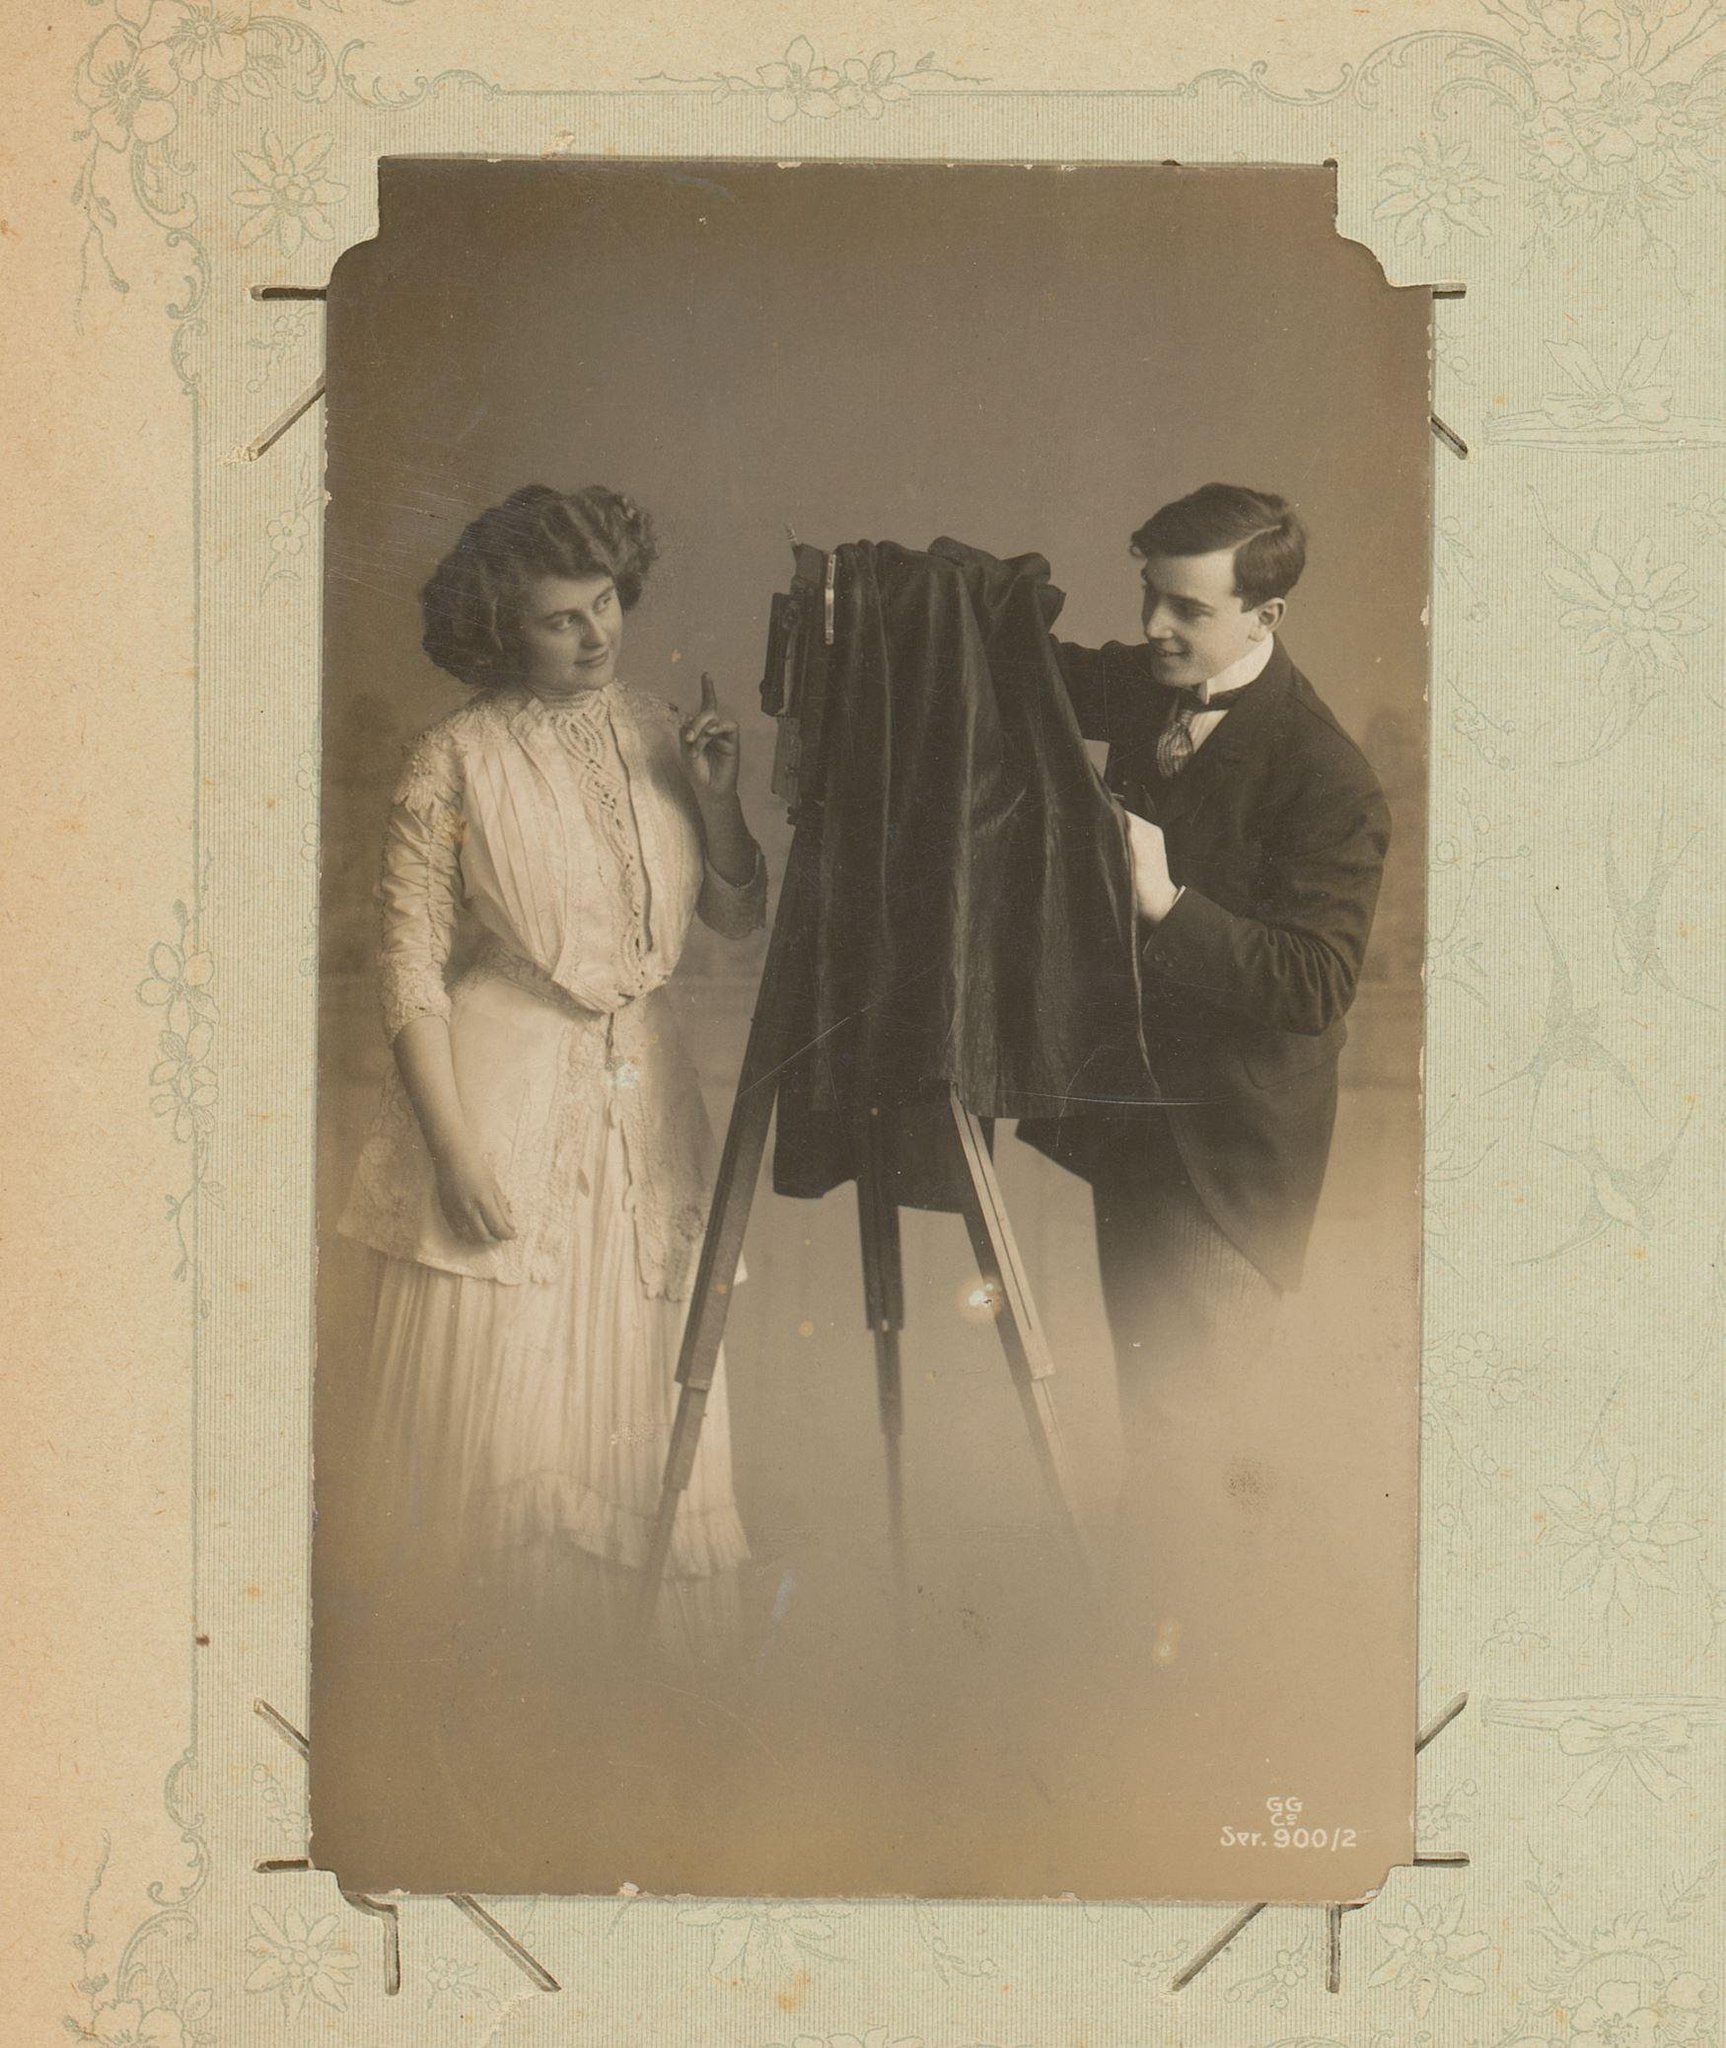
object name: photograph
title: Man fotografeert een vrouw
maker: Anonymous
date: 1900-1950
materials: photographic support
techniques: gelatin silver print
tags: adult woman, taking photographs, adult man, historical persons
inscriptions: inscription: ‘GC/ CP/ Ser 900/2’